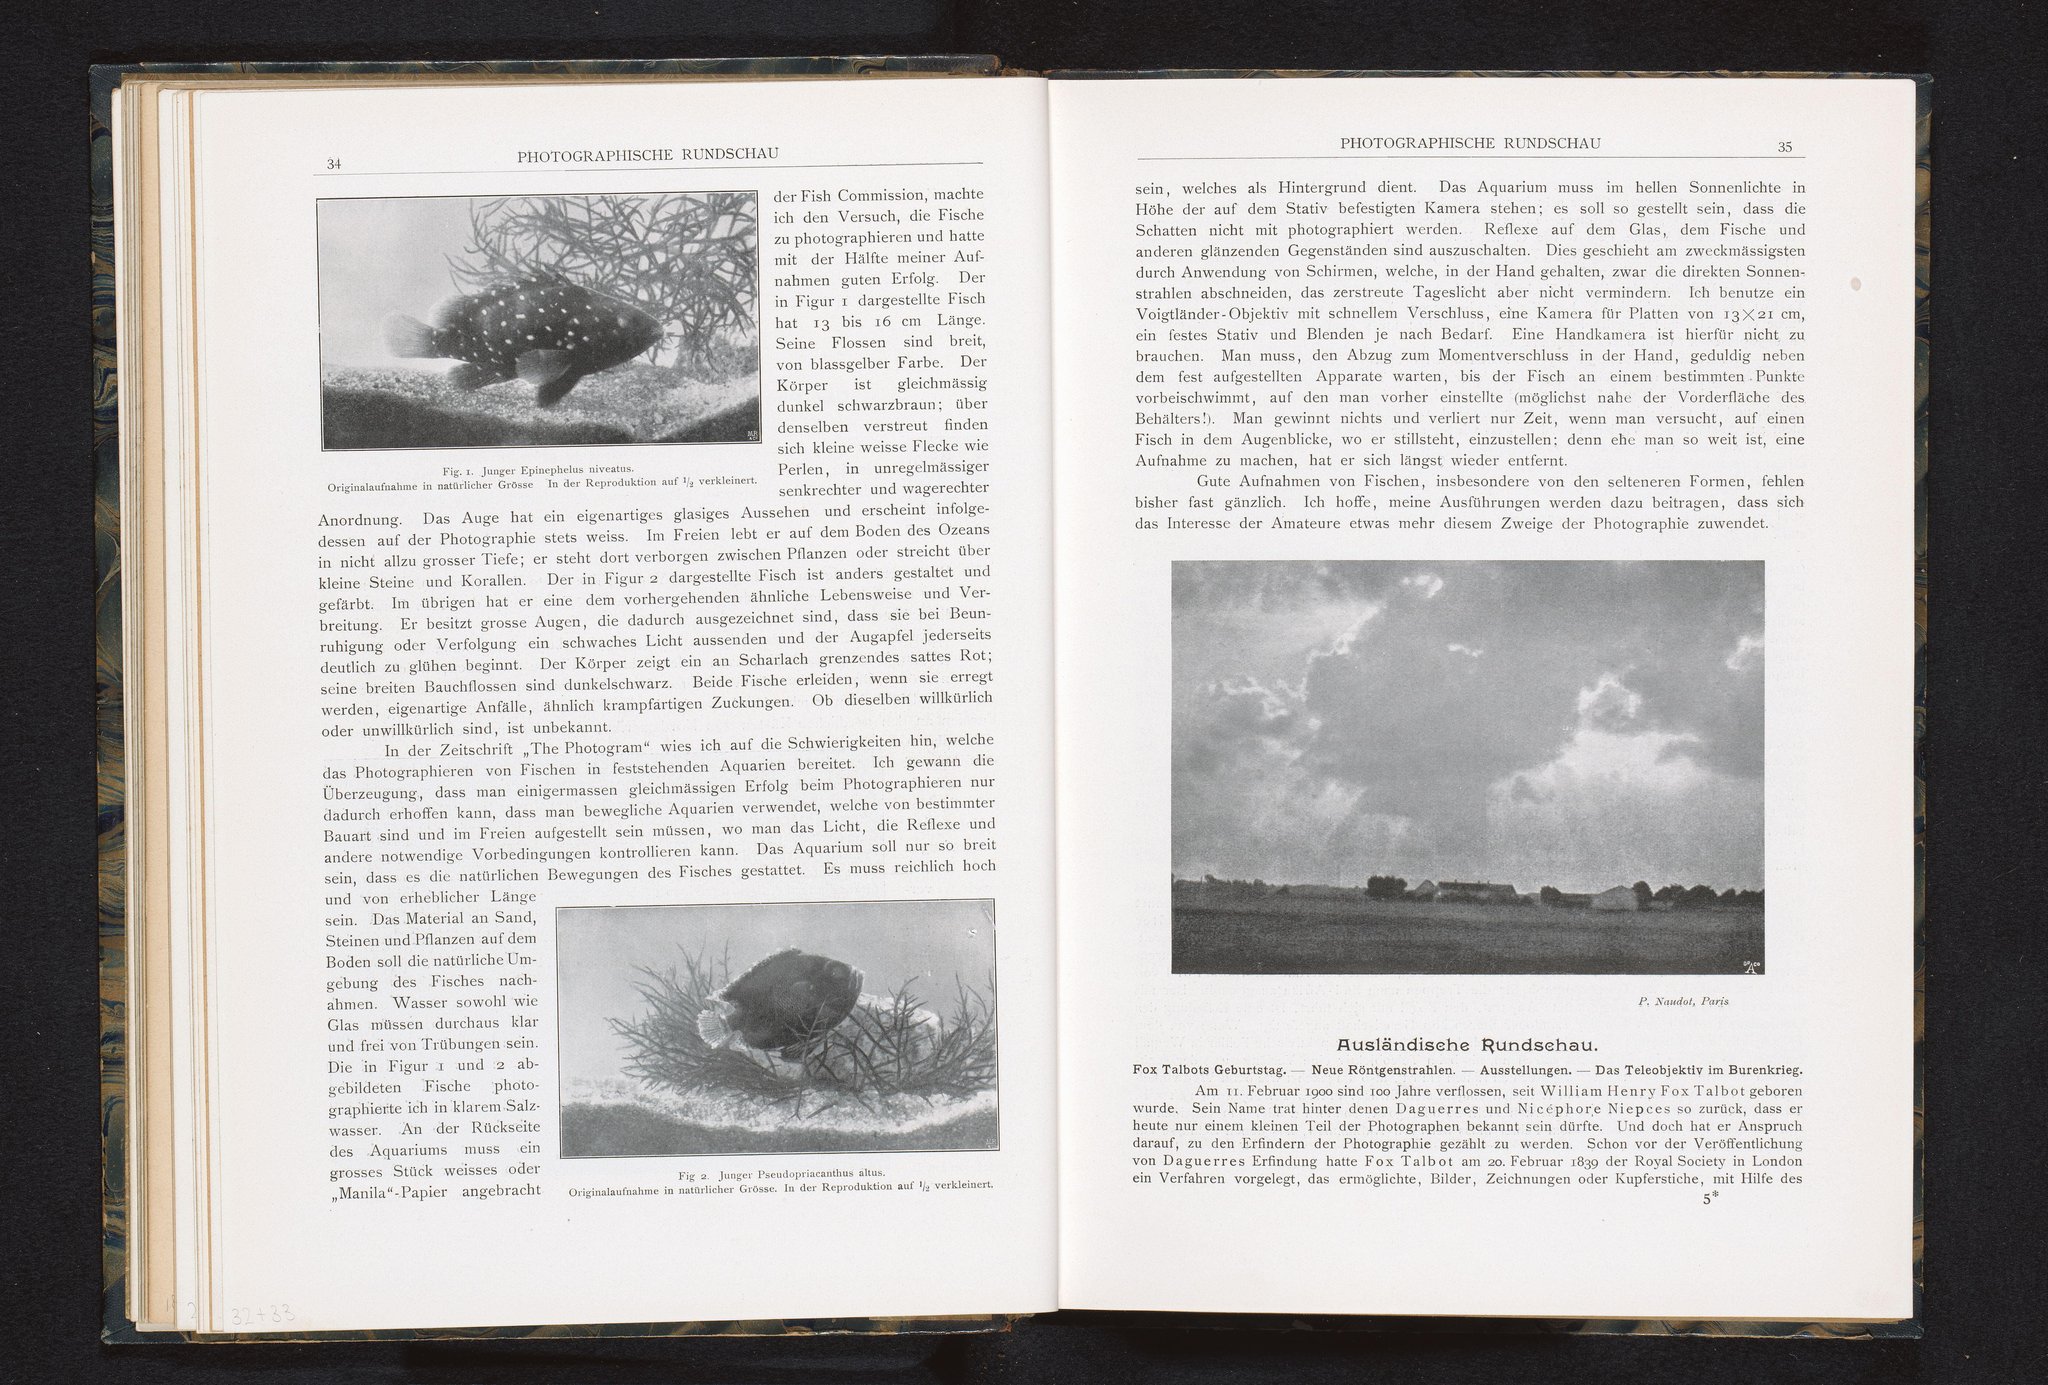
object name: page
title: Hyporthodus niveatus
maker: Anonymous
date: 1895-1900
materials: paper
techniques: autotype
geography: berlin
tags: fishes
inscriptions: inscription: ‘Originalaufnahme in natürlicher größe In der Reproduktion auf 1/2 verkleinert.’